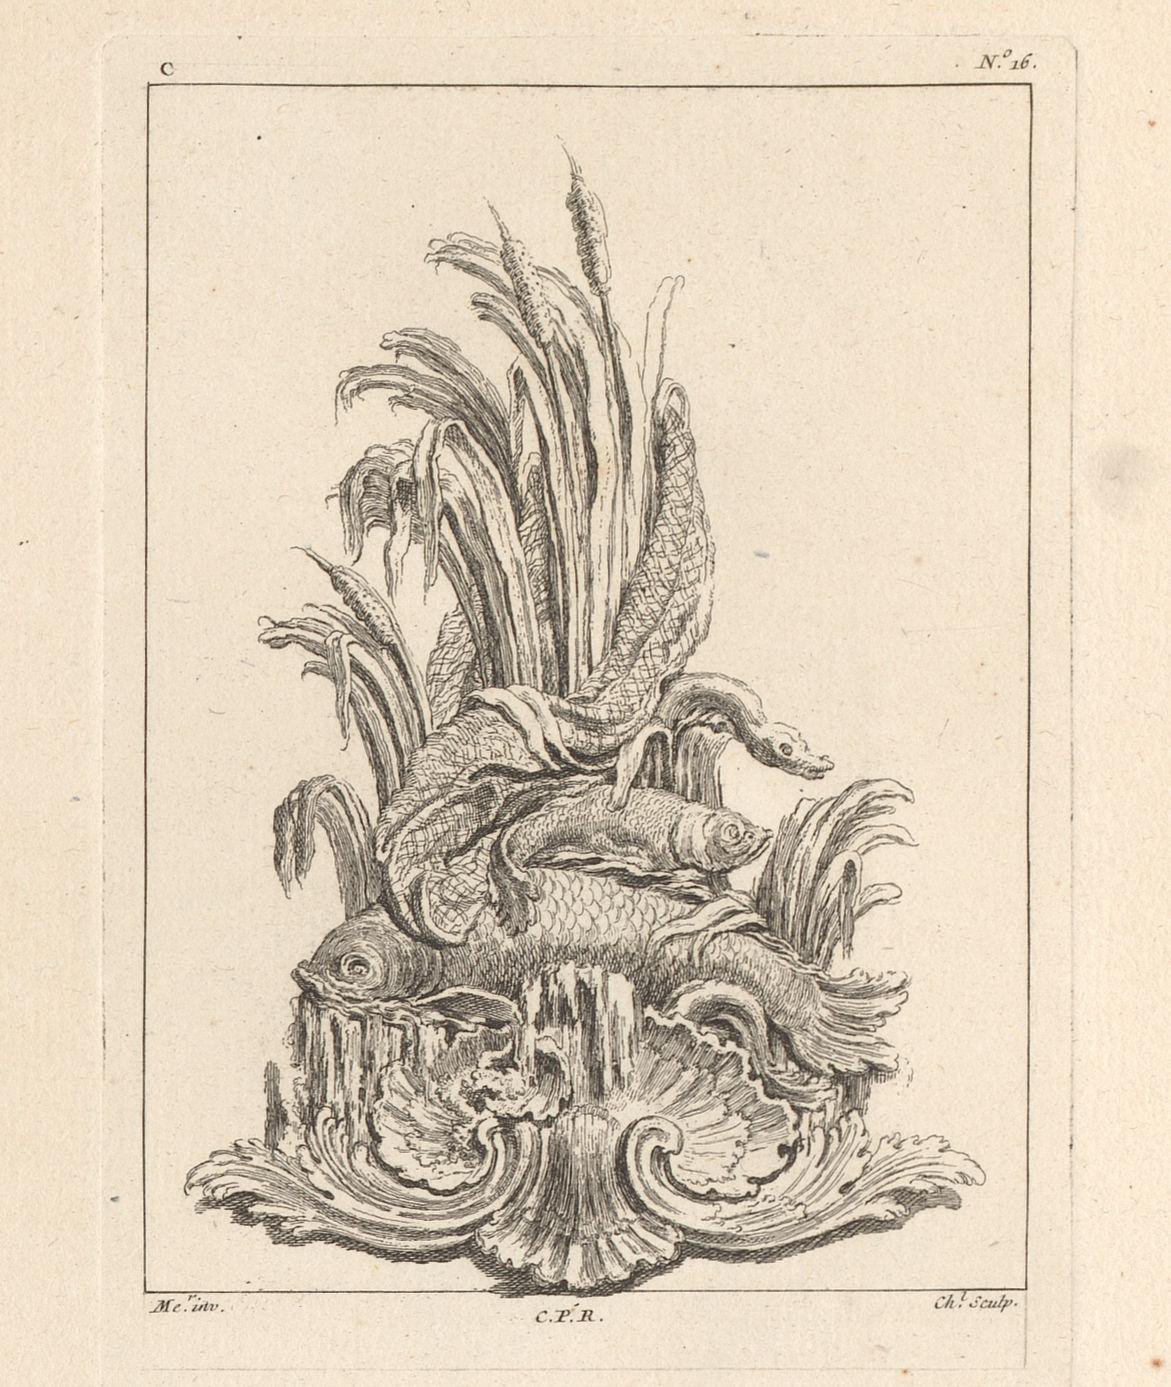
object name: album leaf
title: Oeuvre de Juste Aurele Meissonnier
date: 1738-1749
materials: paper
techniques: etching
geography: paris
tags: fishing net, fishes, scallop, shell ~ ornament, plants and herbs: reed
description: Prent uit een serie van zeven ornamentprenten met soortgelijke voorstellingen. Deze serie ( 'Livre de legumes') is onderdeel van de grotere reeks die het oeuvre van Meissonnier vertoont.